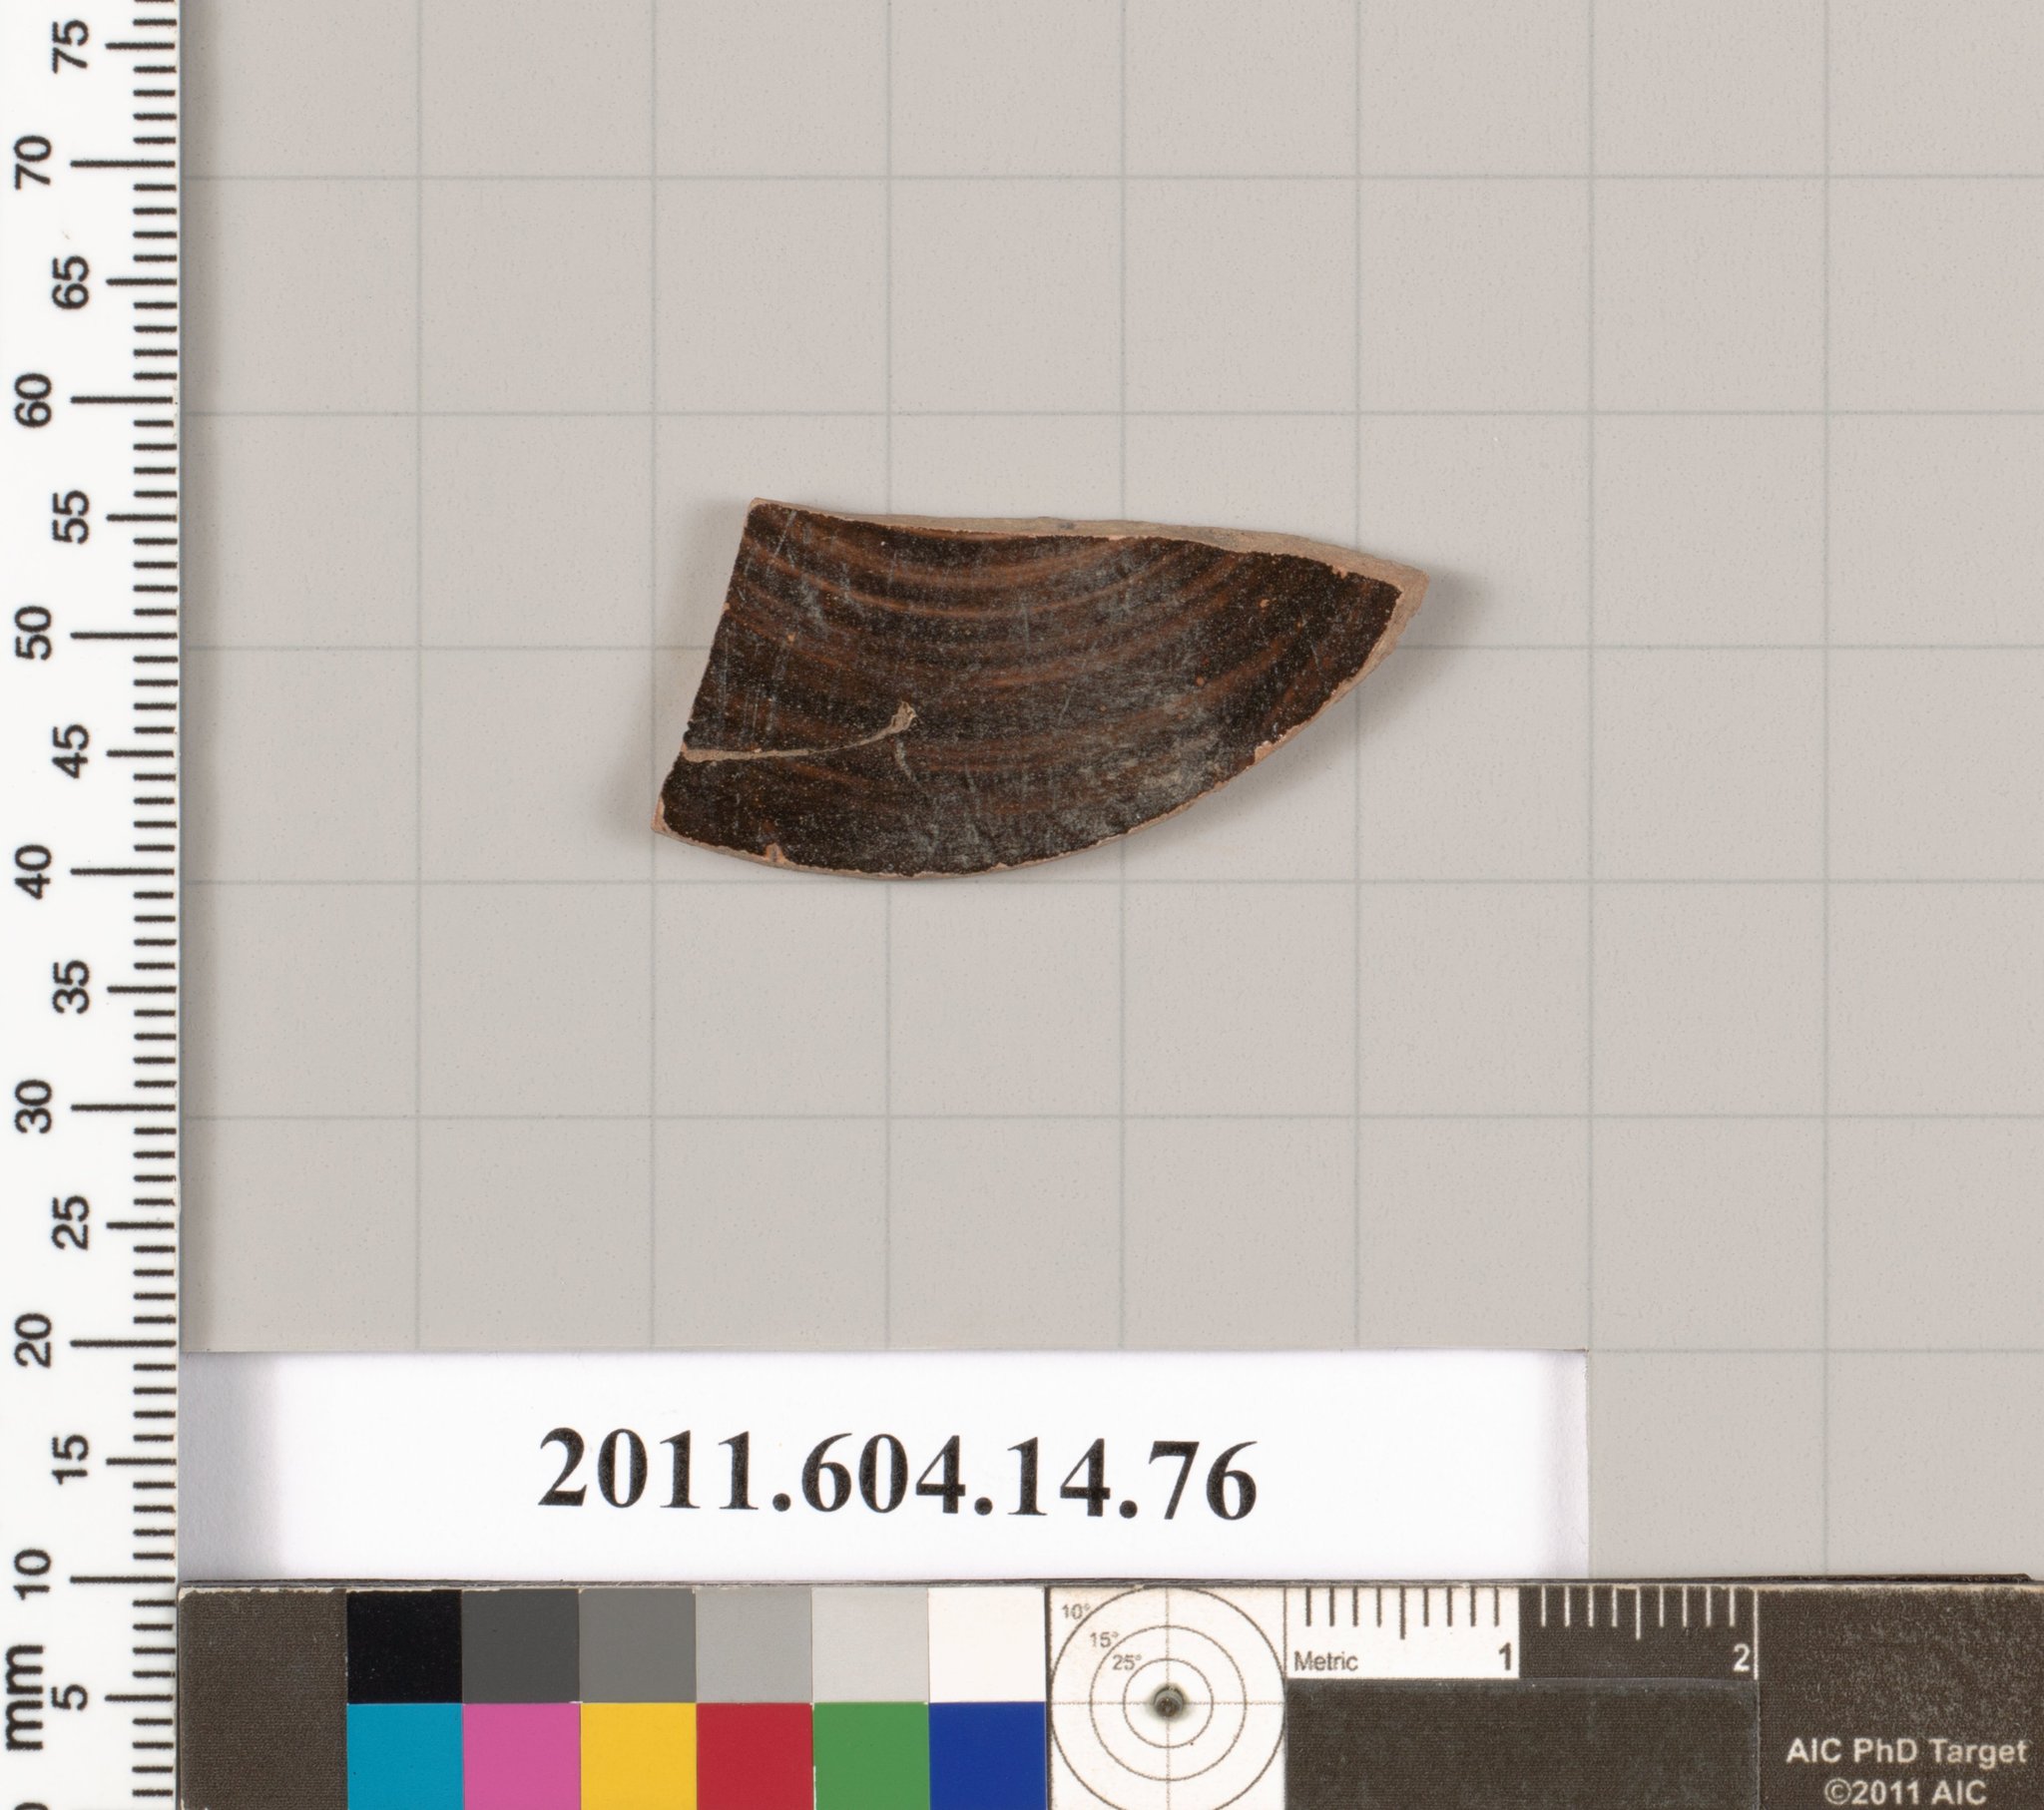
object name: kylix fragment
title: Terracotta fragment of a kylix (drinking cup)?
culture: unknown fabric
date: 600-301 BCE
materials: terracotta